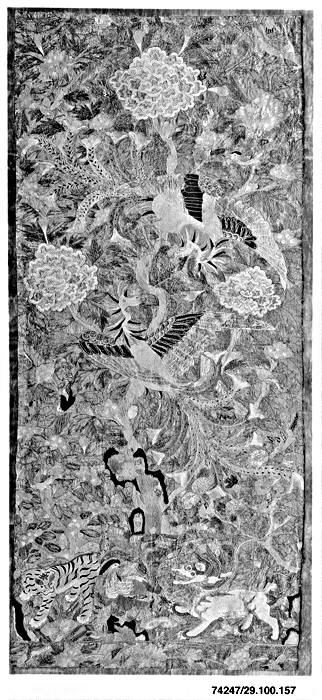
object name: panel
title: Vertical panel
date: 1501-1600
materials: metal thread, silk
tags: birds,tigers,flowers